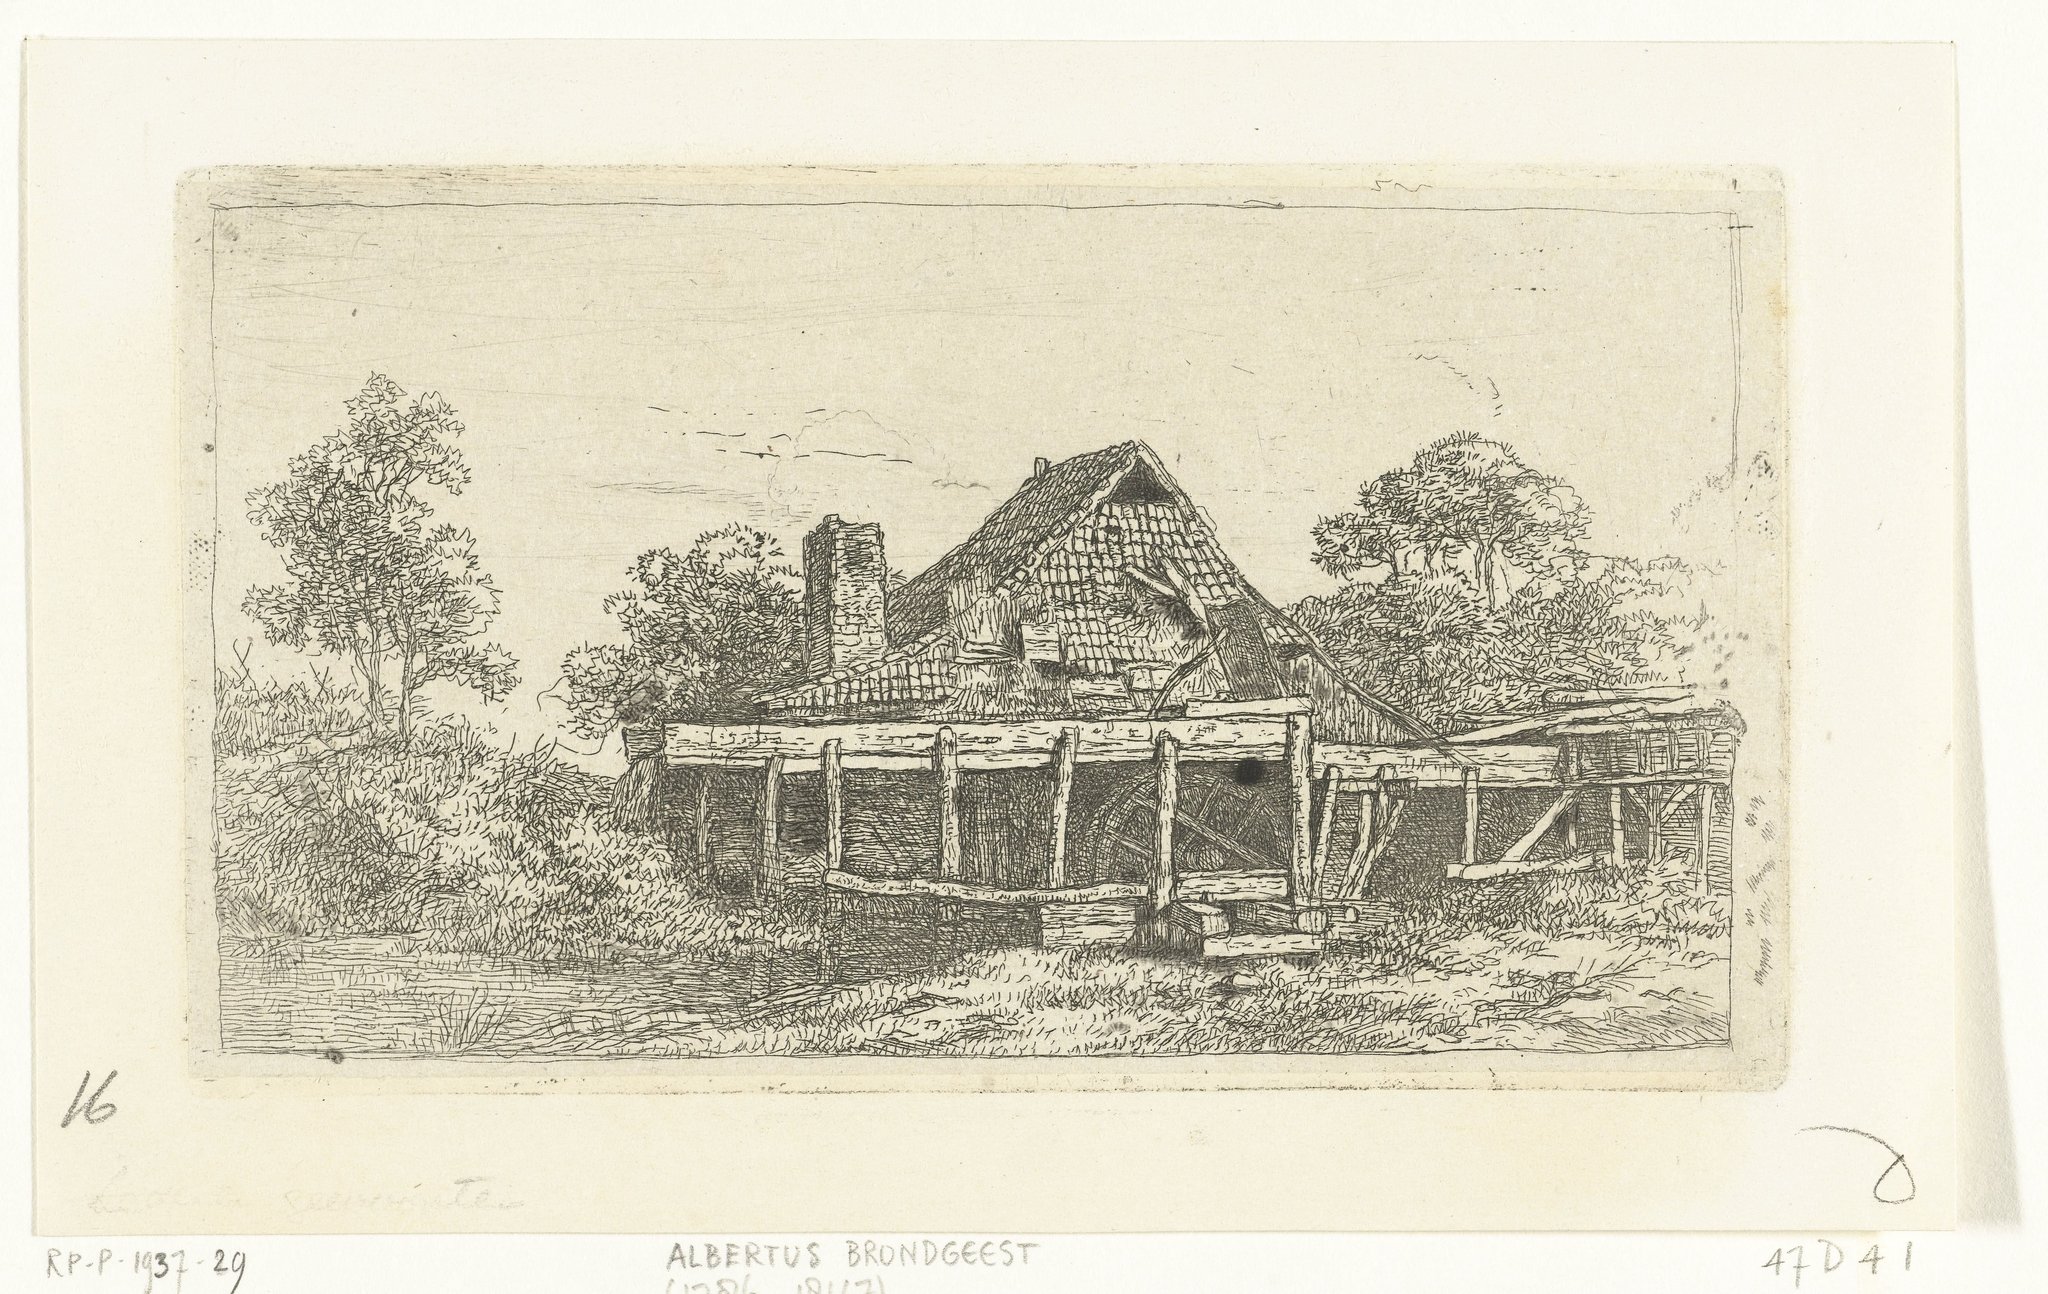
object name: print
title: Landschap met watermolen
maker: albertus brondgeest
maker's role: draughtsman, print maker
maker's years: 1786-1849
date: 1796-1849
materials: paper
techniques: etching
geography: netherlands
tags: watermill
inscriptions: collector's mark: Lugt 2228, collector's mark: Lugt 2760